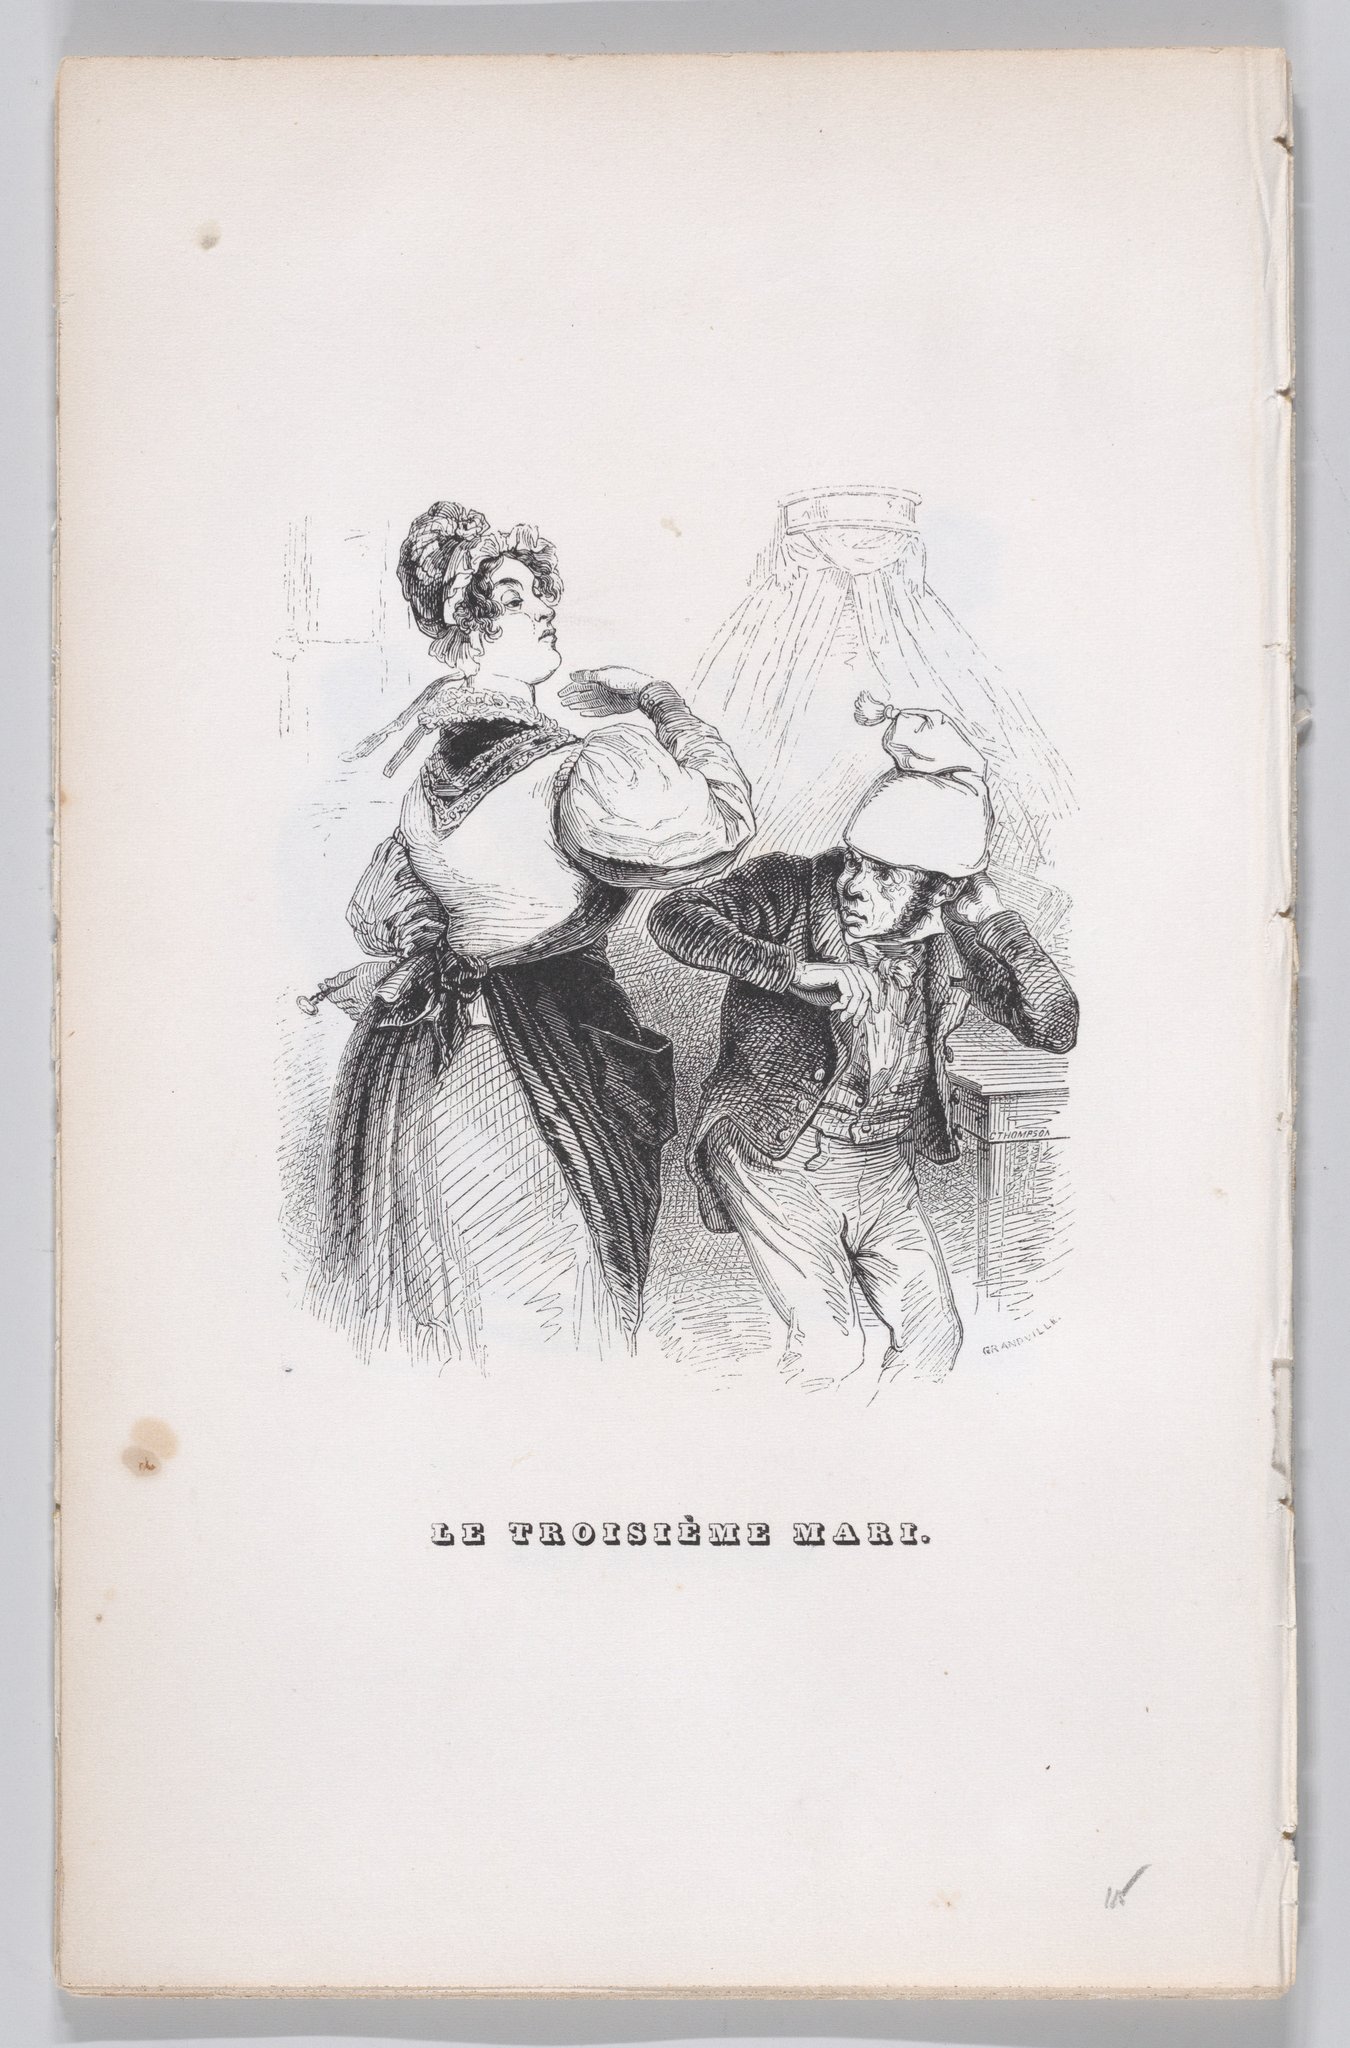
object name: print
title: The Third Husband, from "The Complete Works of Béranger"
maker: j. j. grandville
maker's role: illustrator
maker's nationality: french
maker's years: 1803-1847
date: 1836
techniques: engraving